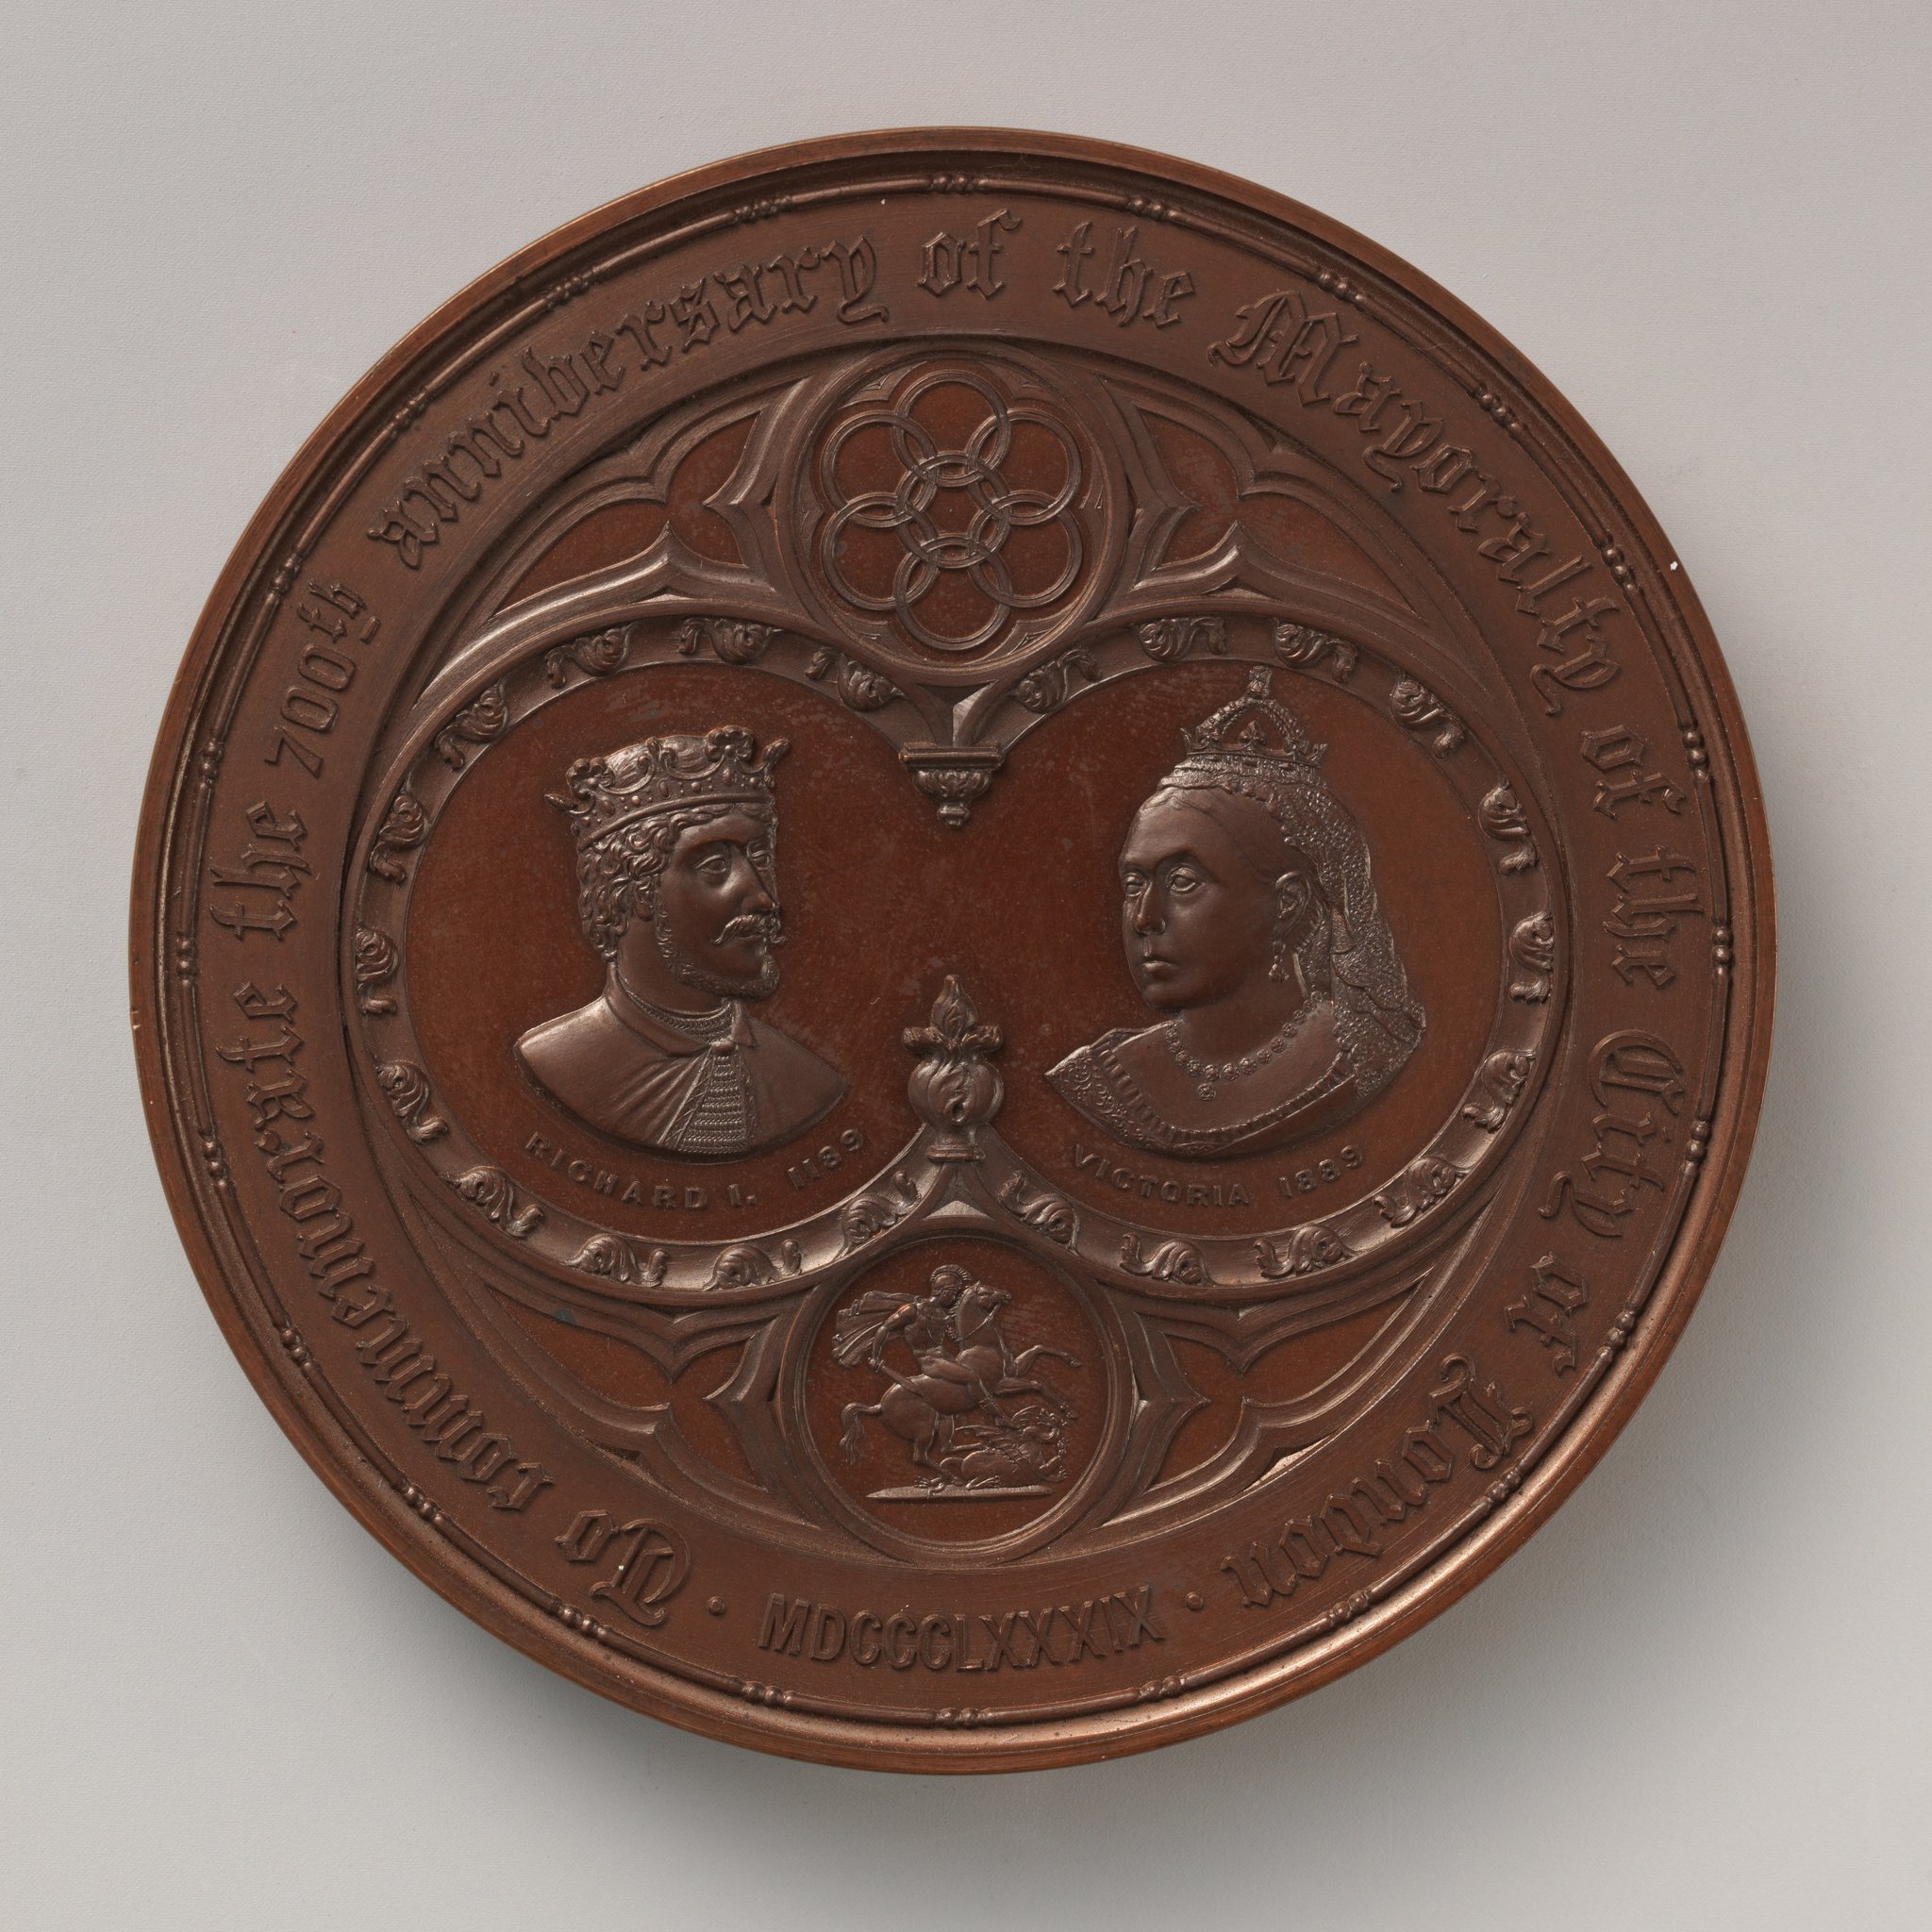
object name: medal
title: To Commemorate the 700th Anniversary of the Mayoralty of London, 1889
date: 1889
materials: bronze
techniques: struck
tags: men,profiles,women,horses